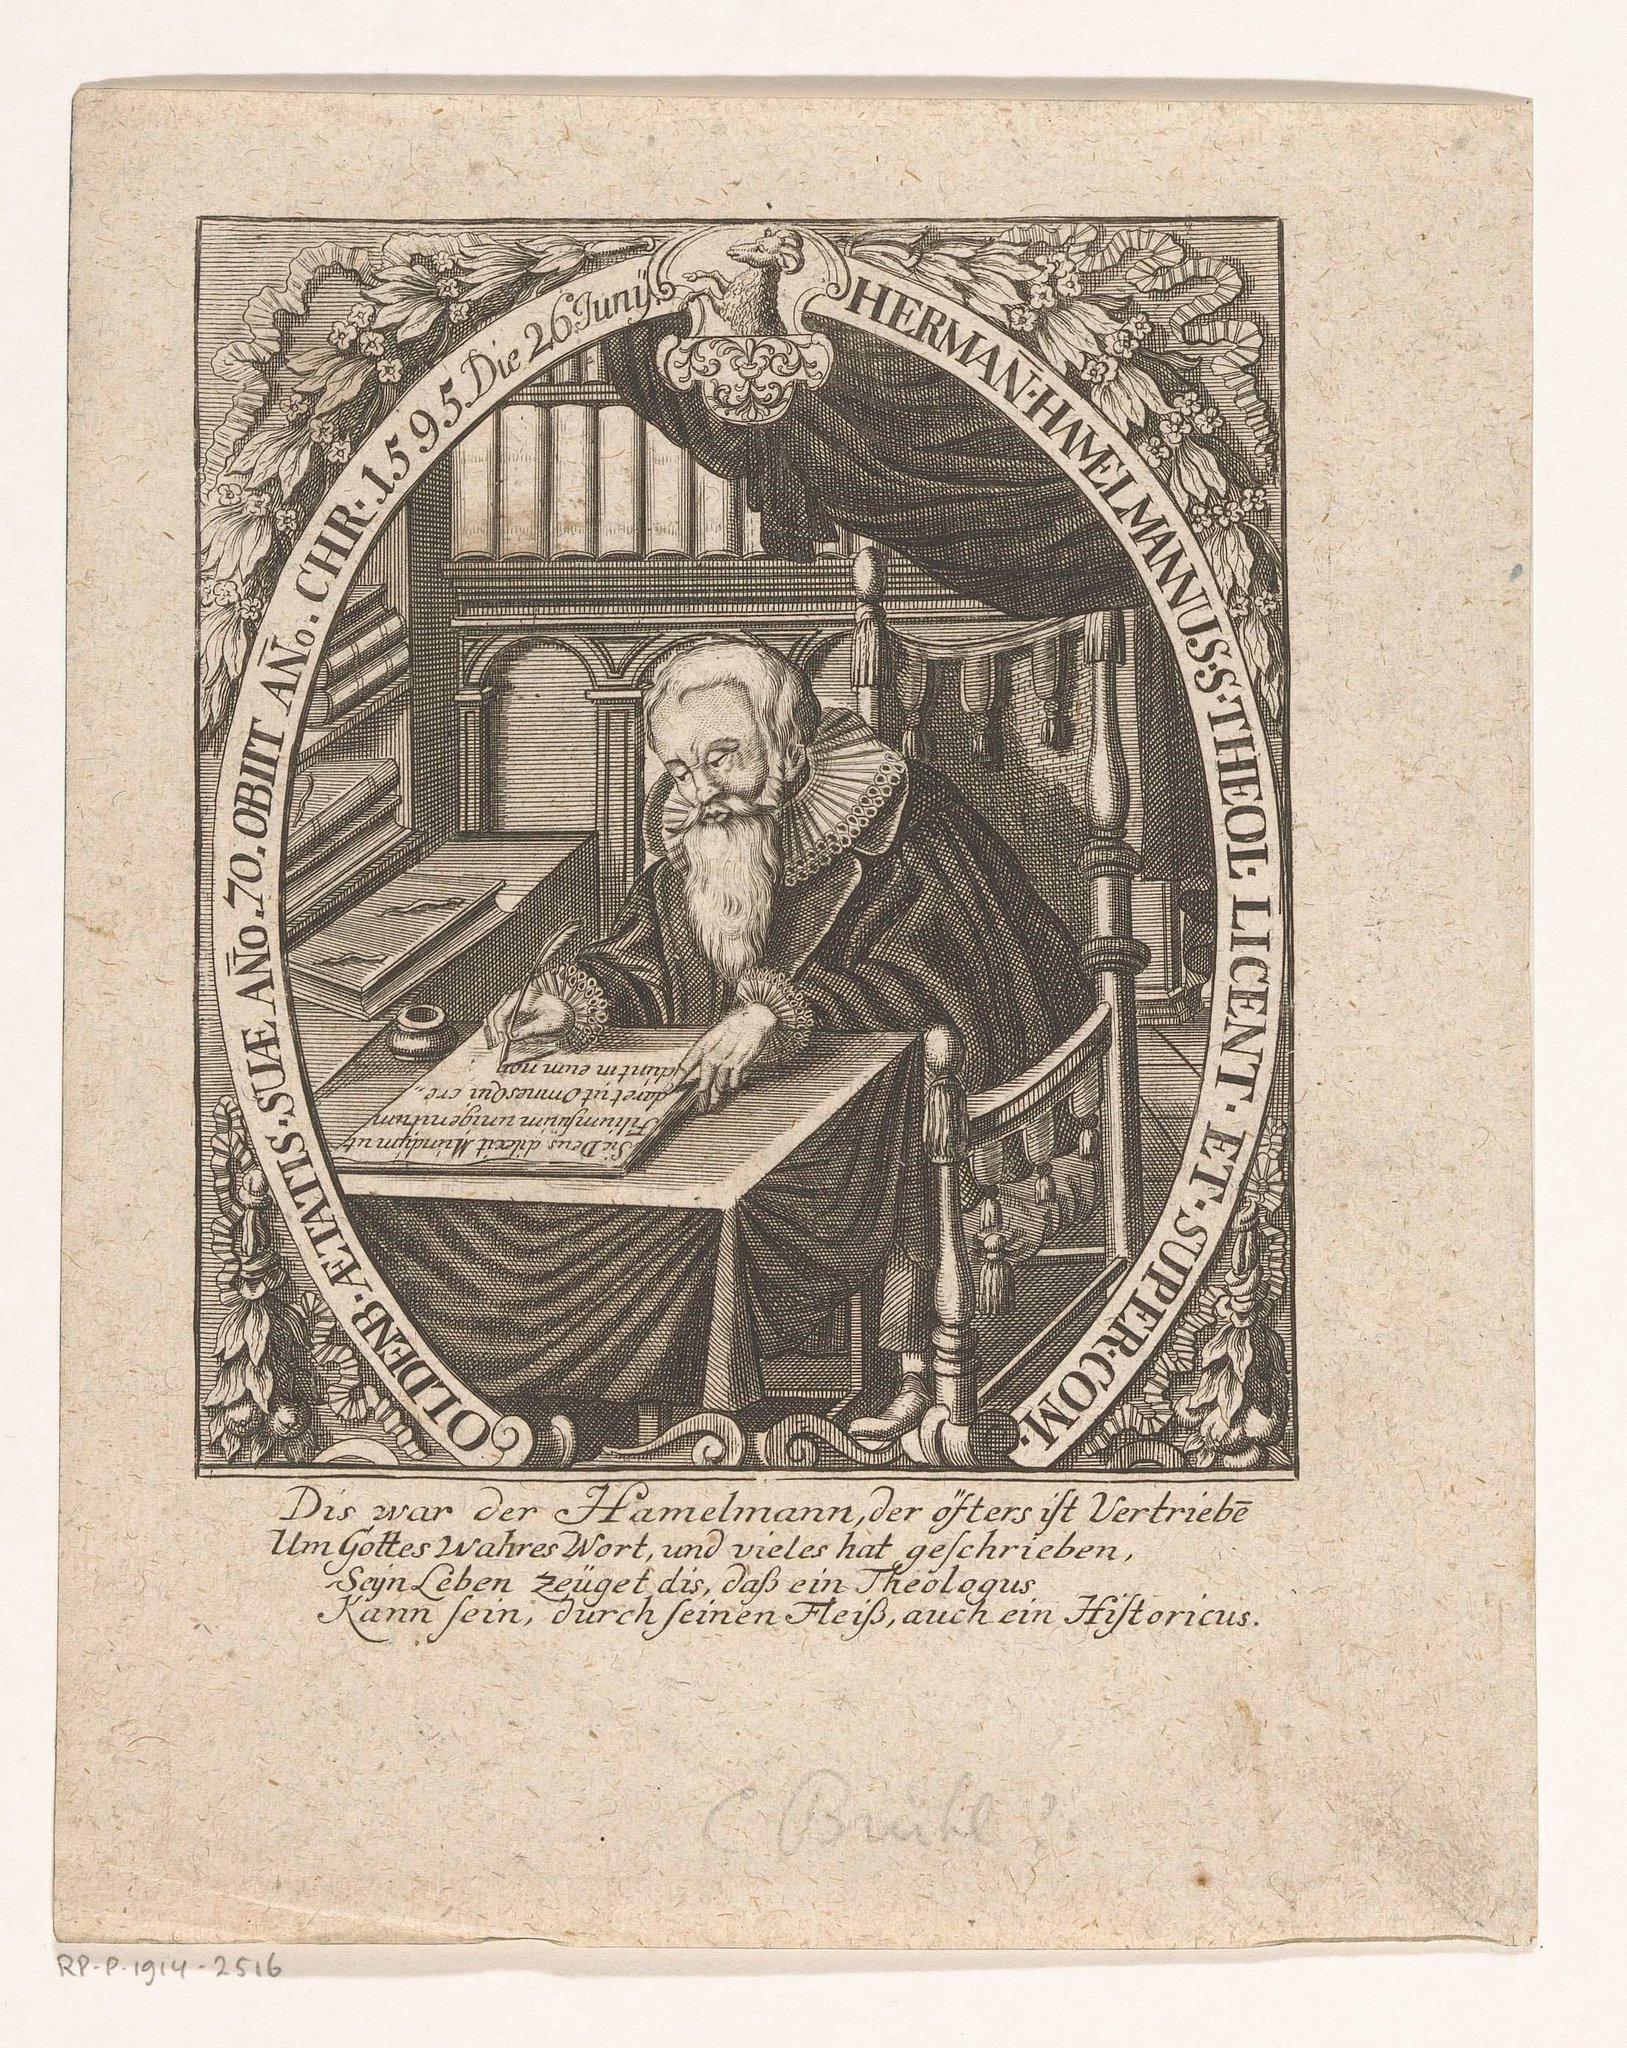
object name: print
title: Portret van Hermann Hamelmann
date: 1701-1763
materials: paper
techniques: engraving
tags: handwriting, writing as activity, bookshelves, scholar in his study, historical persons, armorial bearing, heraldry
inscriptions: collector's mark: Lugt 2228